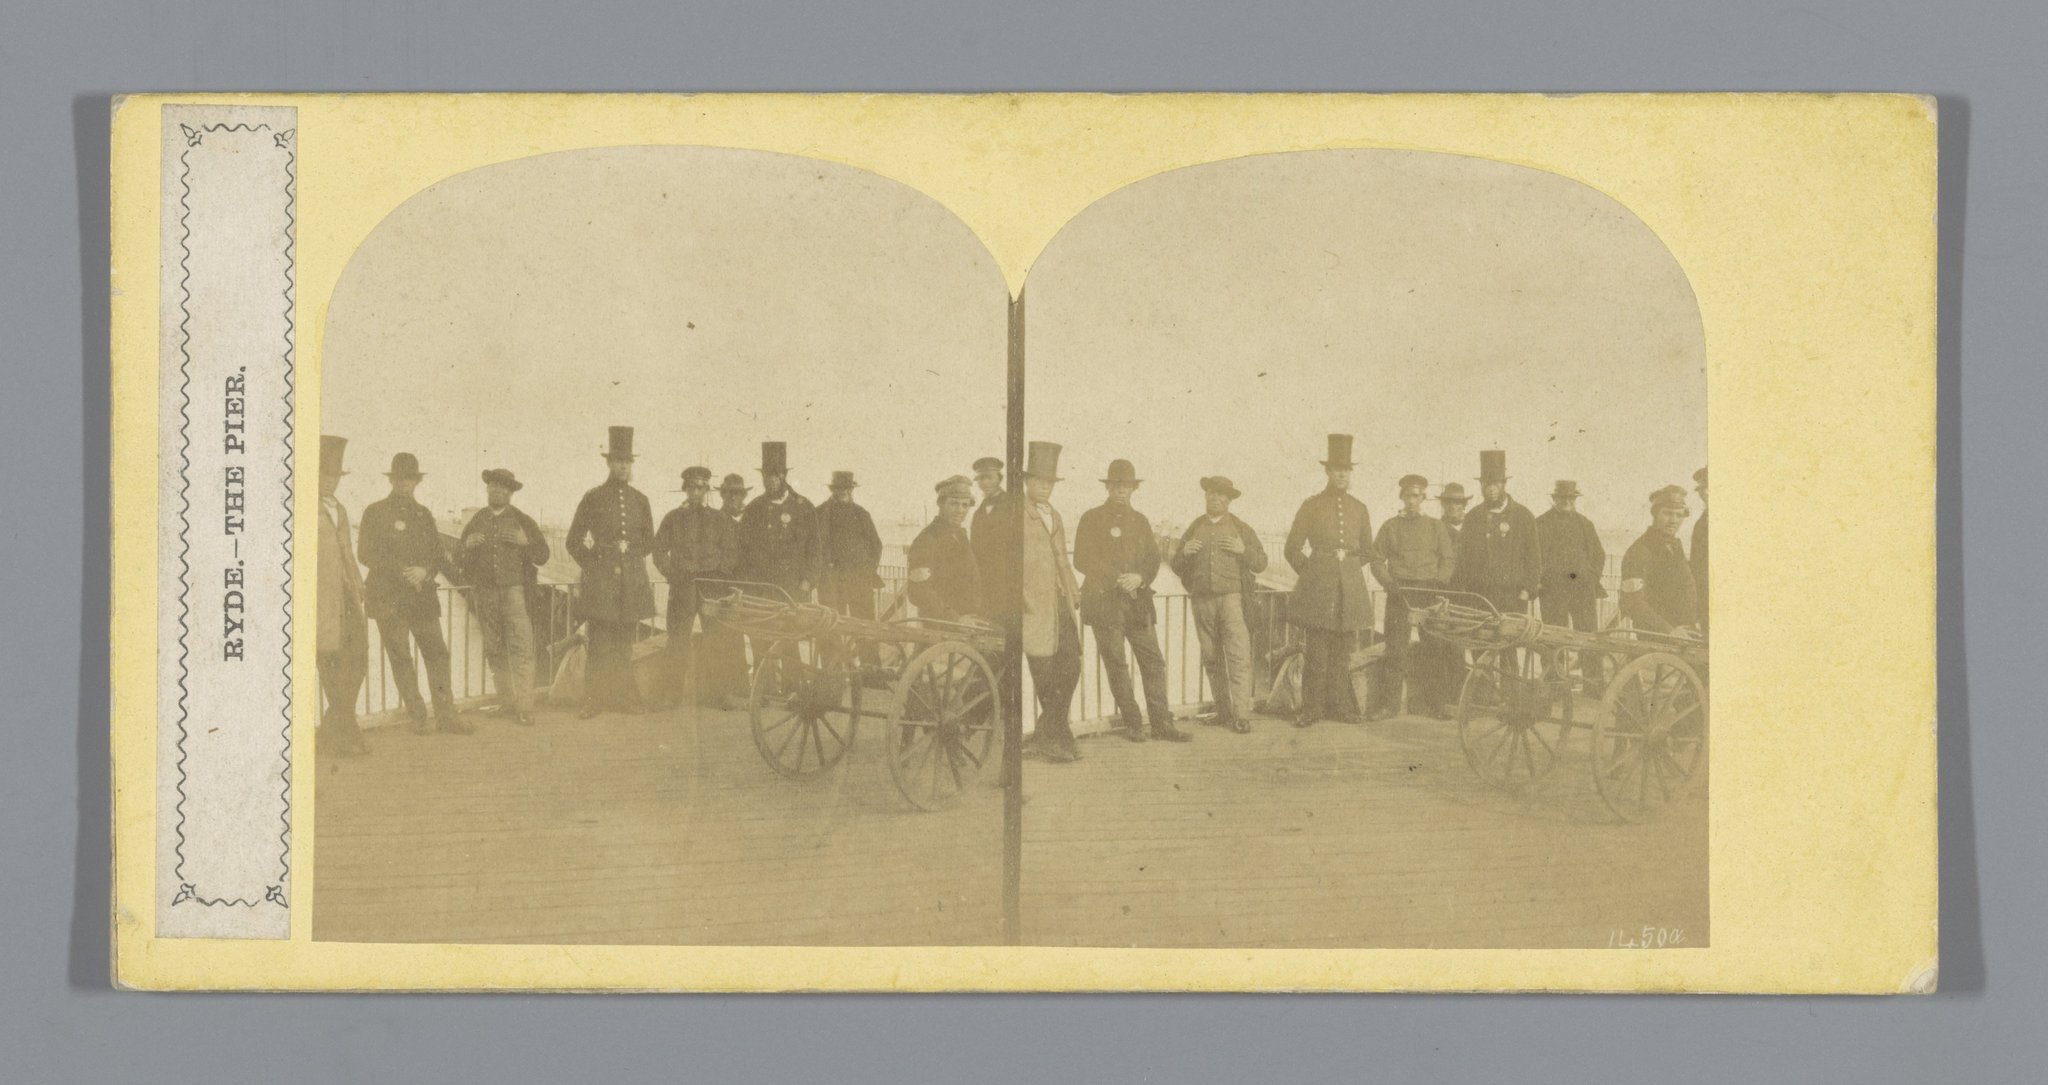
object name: stereograph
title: Ryde-The Pier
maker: Anonymous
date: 1850-1875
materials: cardboard, photographic support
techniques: albumen print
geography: ryde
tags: hand-cart, pier, quay, wharf, anonymous historical persons portrayed in a group, in a group-portrait